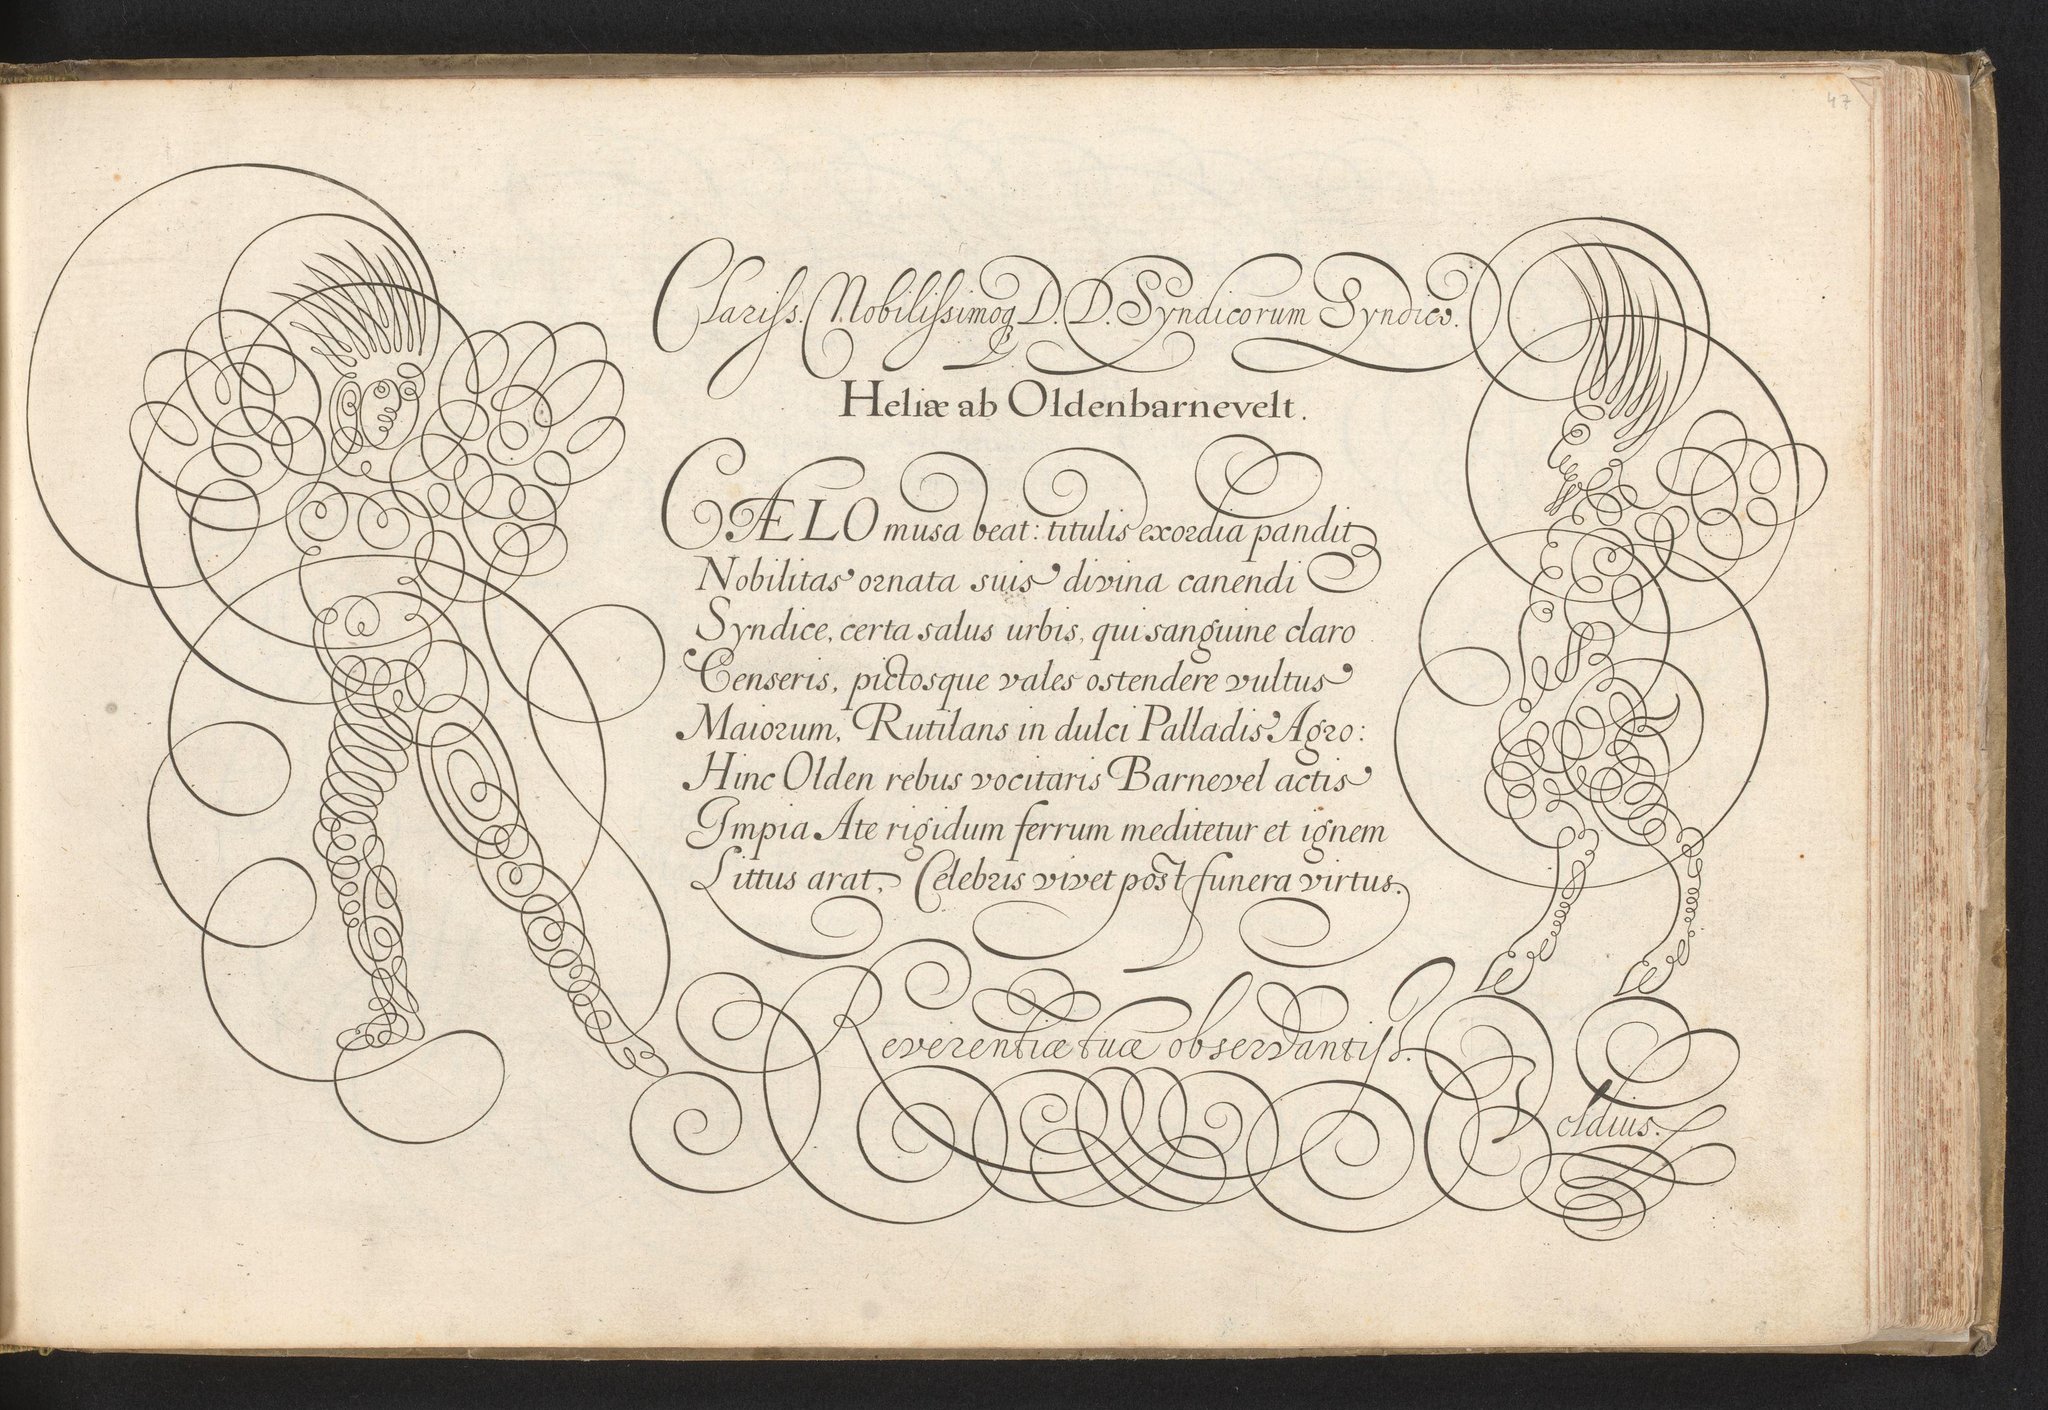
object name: ornament print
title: Spieghel der schrijfkonste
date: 1605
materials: paper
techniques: engraving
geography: haarlem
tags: satyr(s) (in general), calligraphy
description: Schrijfvoorbeeld met de aanhef: Clarris. nobilissimoq(ue) D.D. syndicorum syndoco Heliae ab Oldenbarnevelt. Daaronder acht regels tekst in het Latijn: Caelo musa beat ... Ondertekend Veldius. Links een menselijk figuur met vleugels in krulwerk, rechts een sater. De prent maakt deel uit van een album.